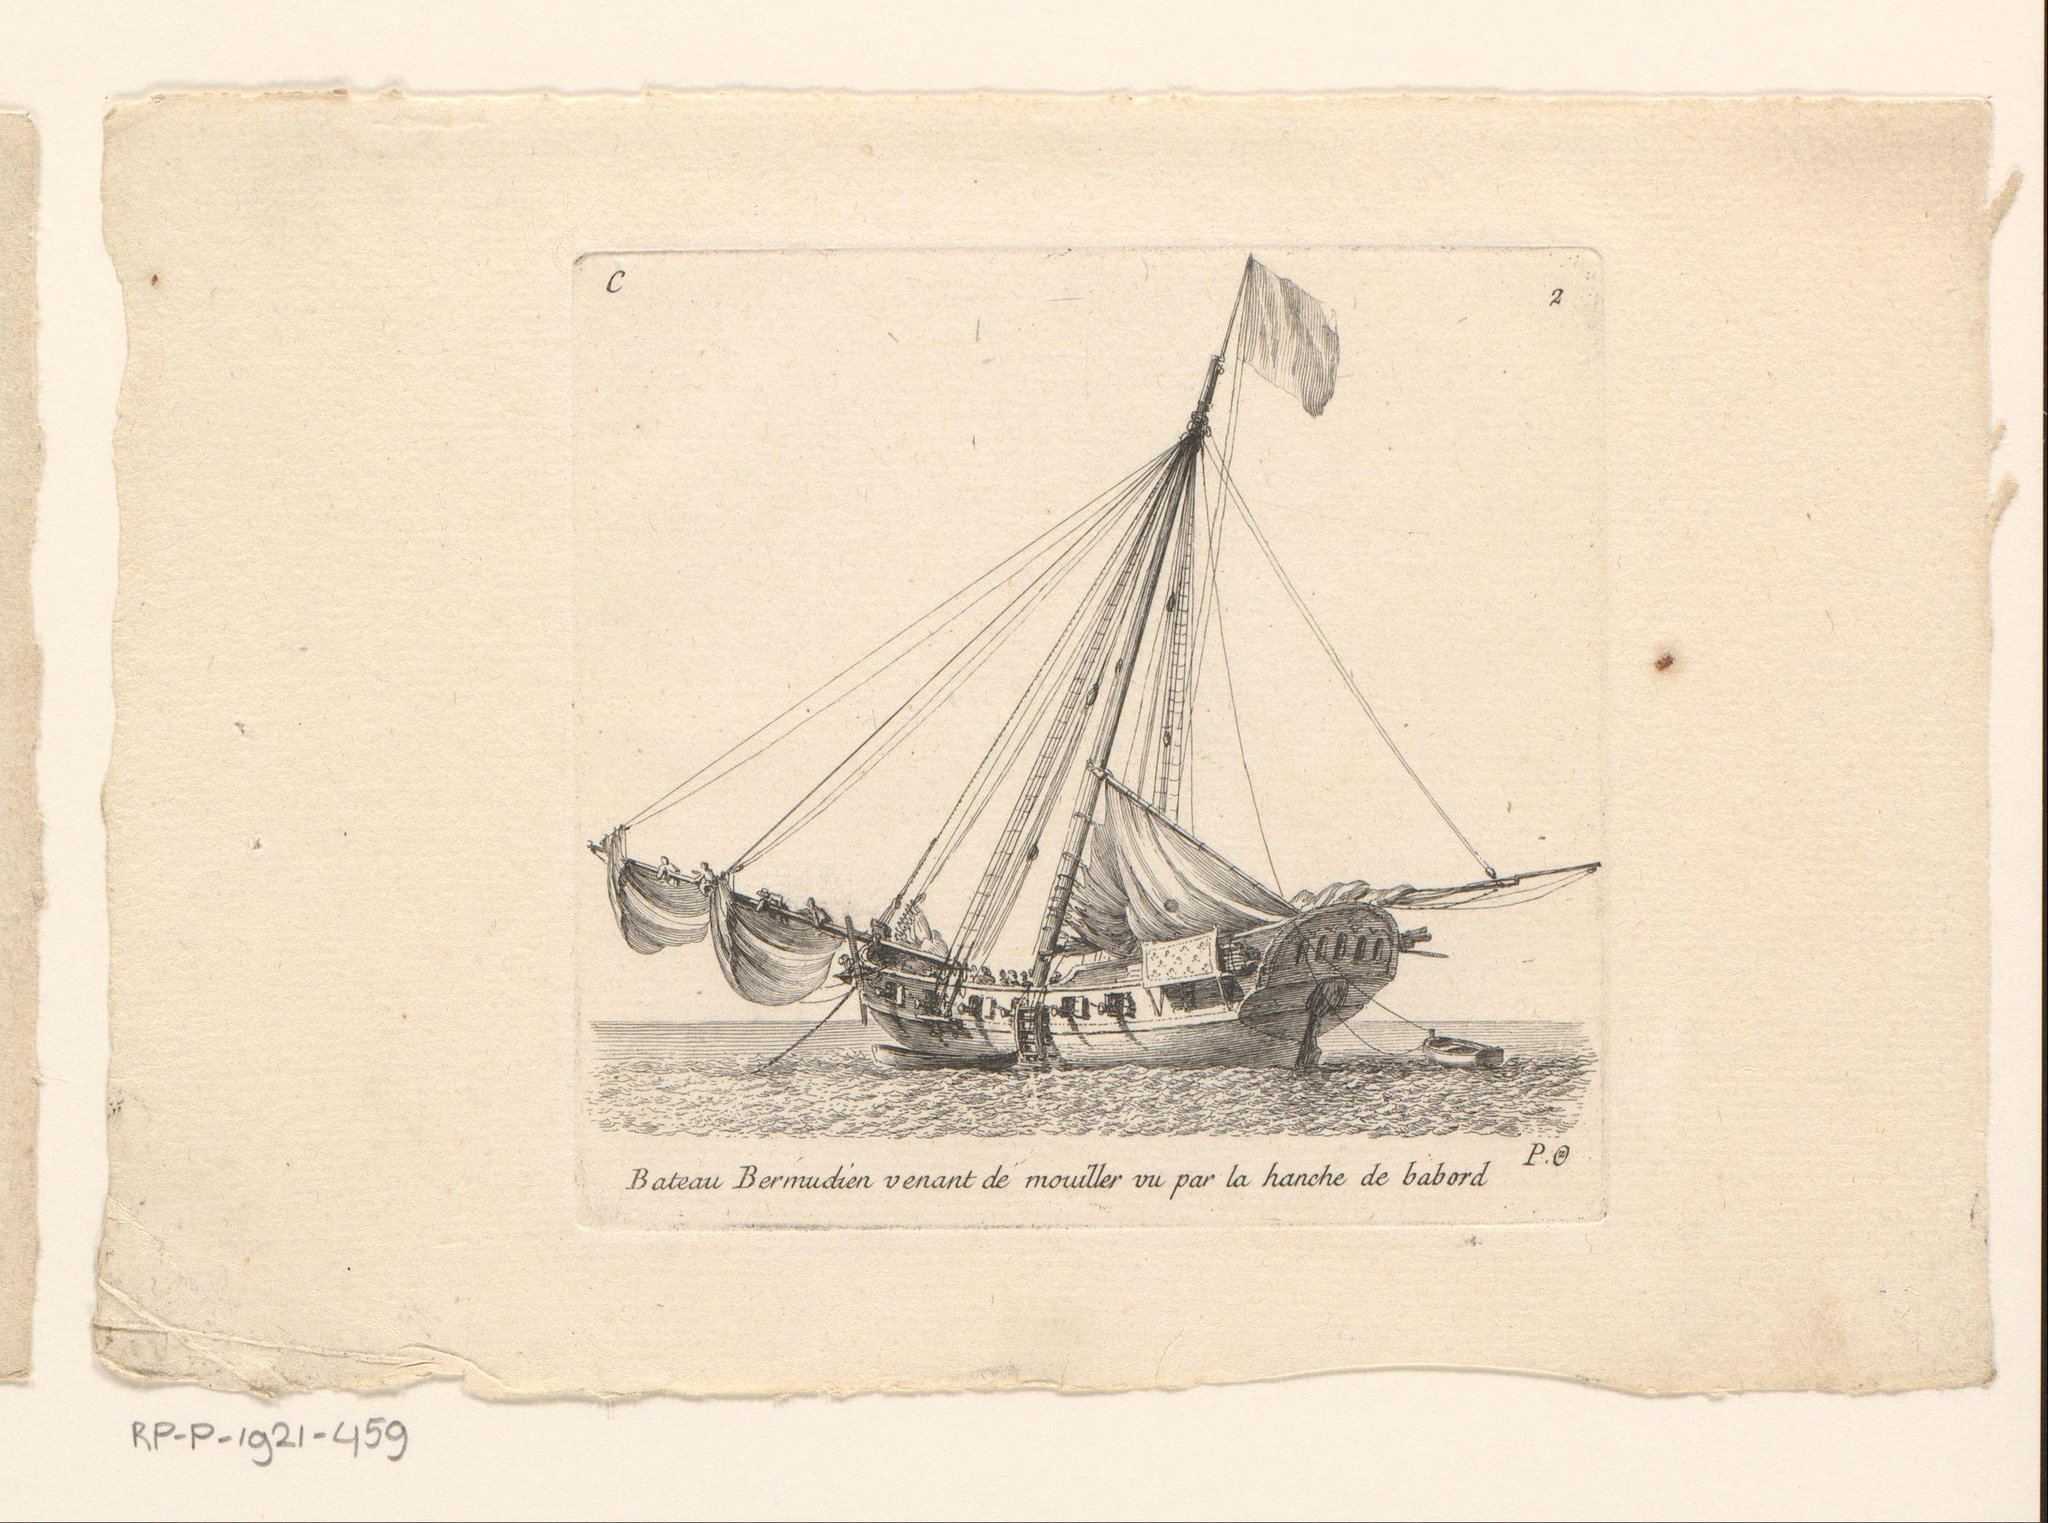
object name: print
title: Melanges de Vaisseaux, de Barques et de Bateaux 3e Cahier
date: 1747-1813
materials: paper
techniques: etching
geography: paris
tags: sailing-ship, sailing-boat, parts of ship's exterior: anchor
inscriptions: collector's mark: Lugt 2233